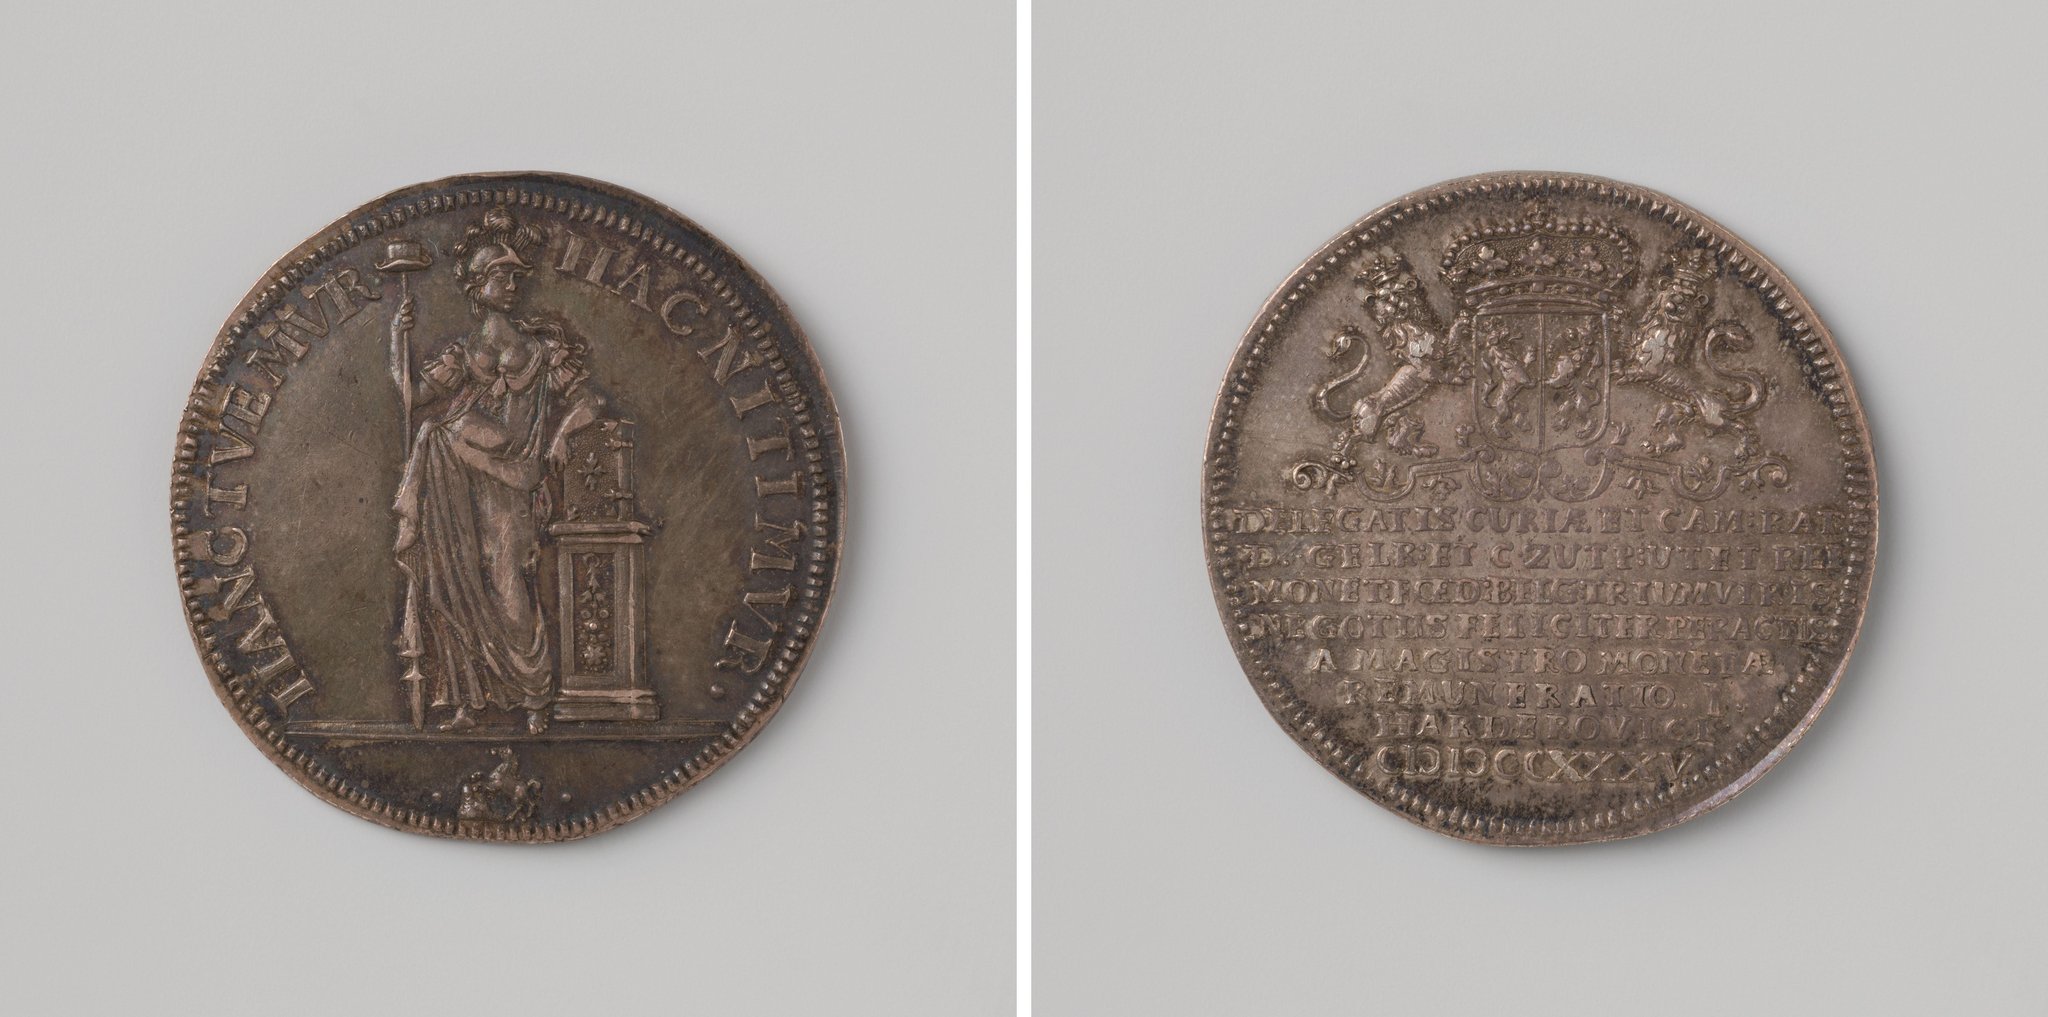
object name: history medal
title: Inspectie van de munt te Harderwijk, penning door muntmeester Johan Hensbergen aan de raden en generaalmuntmeester vereerd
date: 1735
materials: silver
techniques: striking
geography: harderwijk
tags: johannes hensbergen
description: Zilveren penning. Voorzijde: Nederlandse maagd met vrijheidshoed op speer leunt met arm op bijbel staand op altaar binnen omschrift (stempel van twee guldenstuk); onder afbeelding: steigerend paard (merkteken van munt van Harderwijk). Keerzijde: opschrift onder gekroond wapenschild van Gelderland, geflankeerd door twee gekroonde leeuwen.